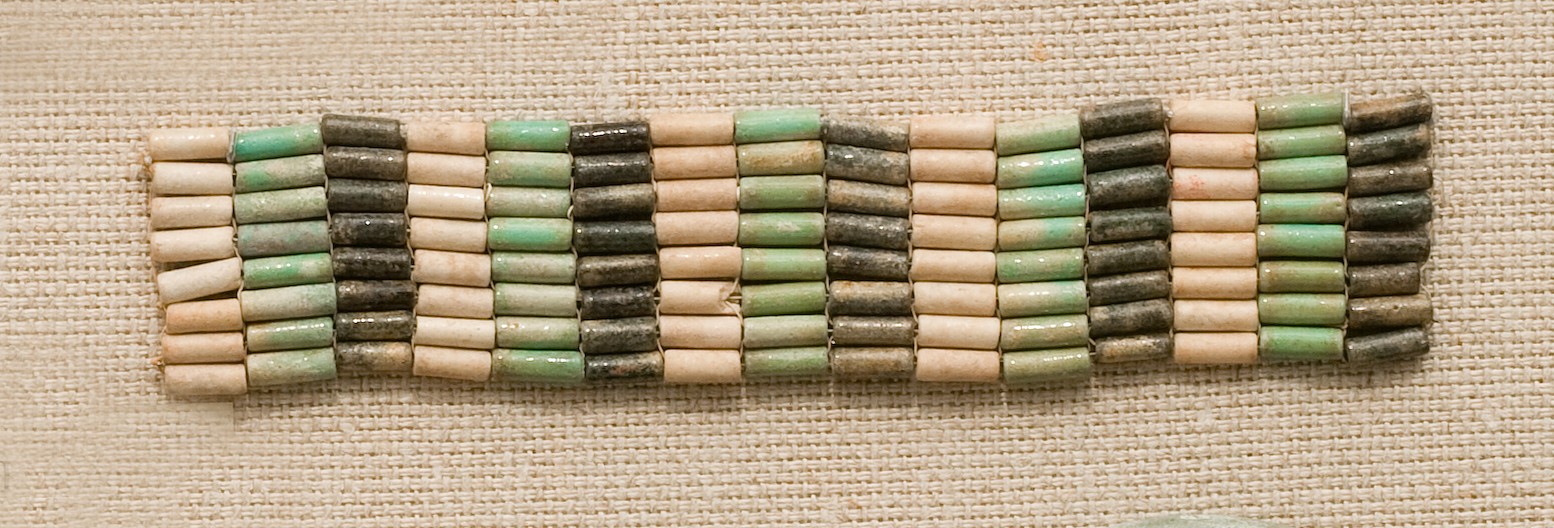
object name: anklet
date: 1981-1640 BCE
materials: faience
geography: egypt